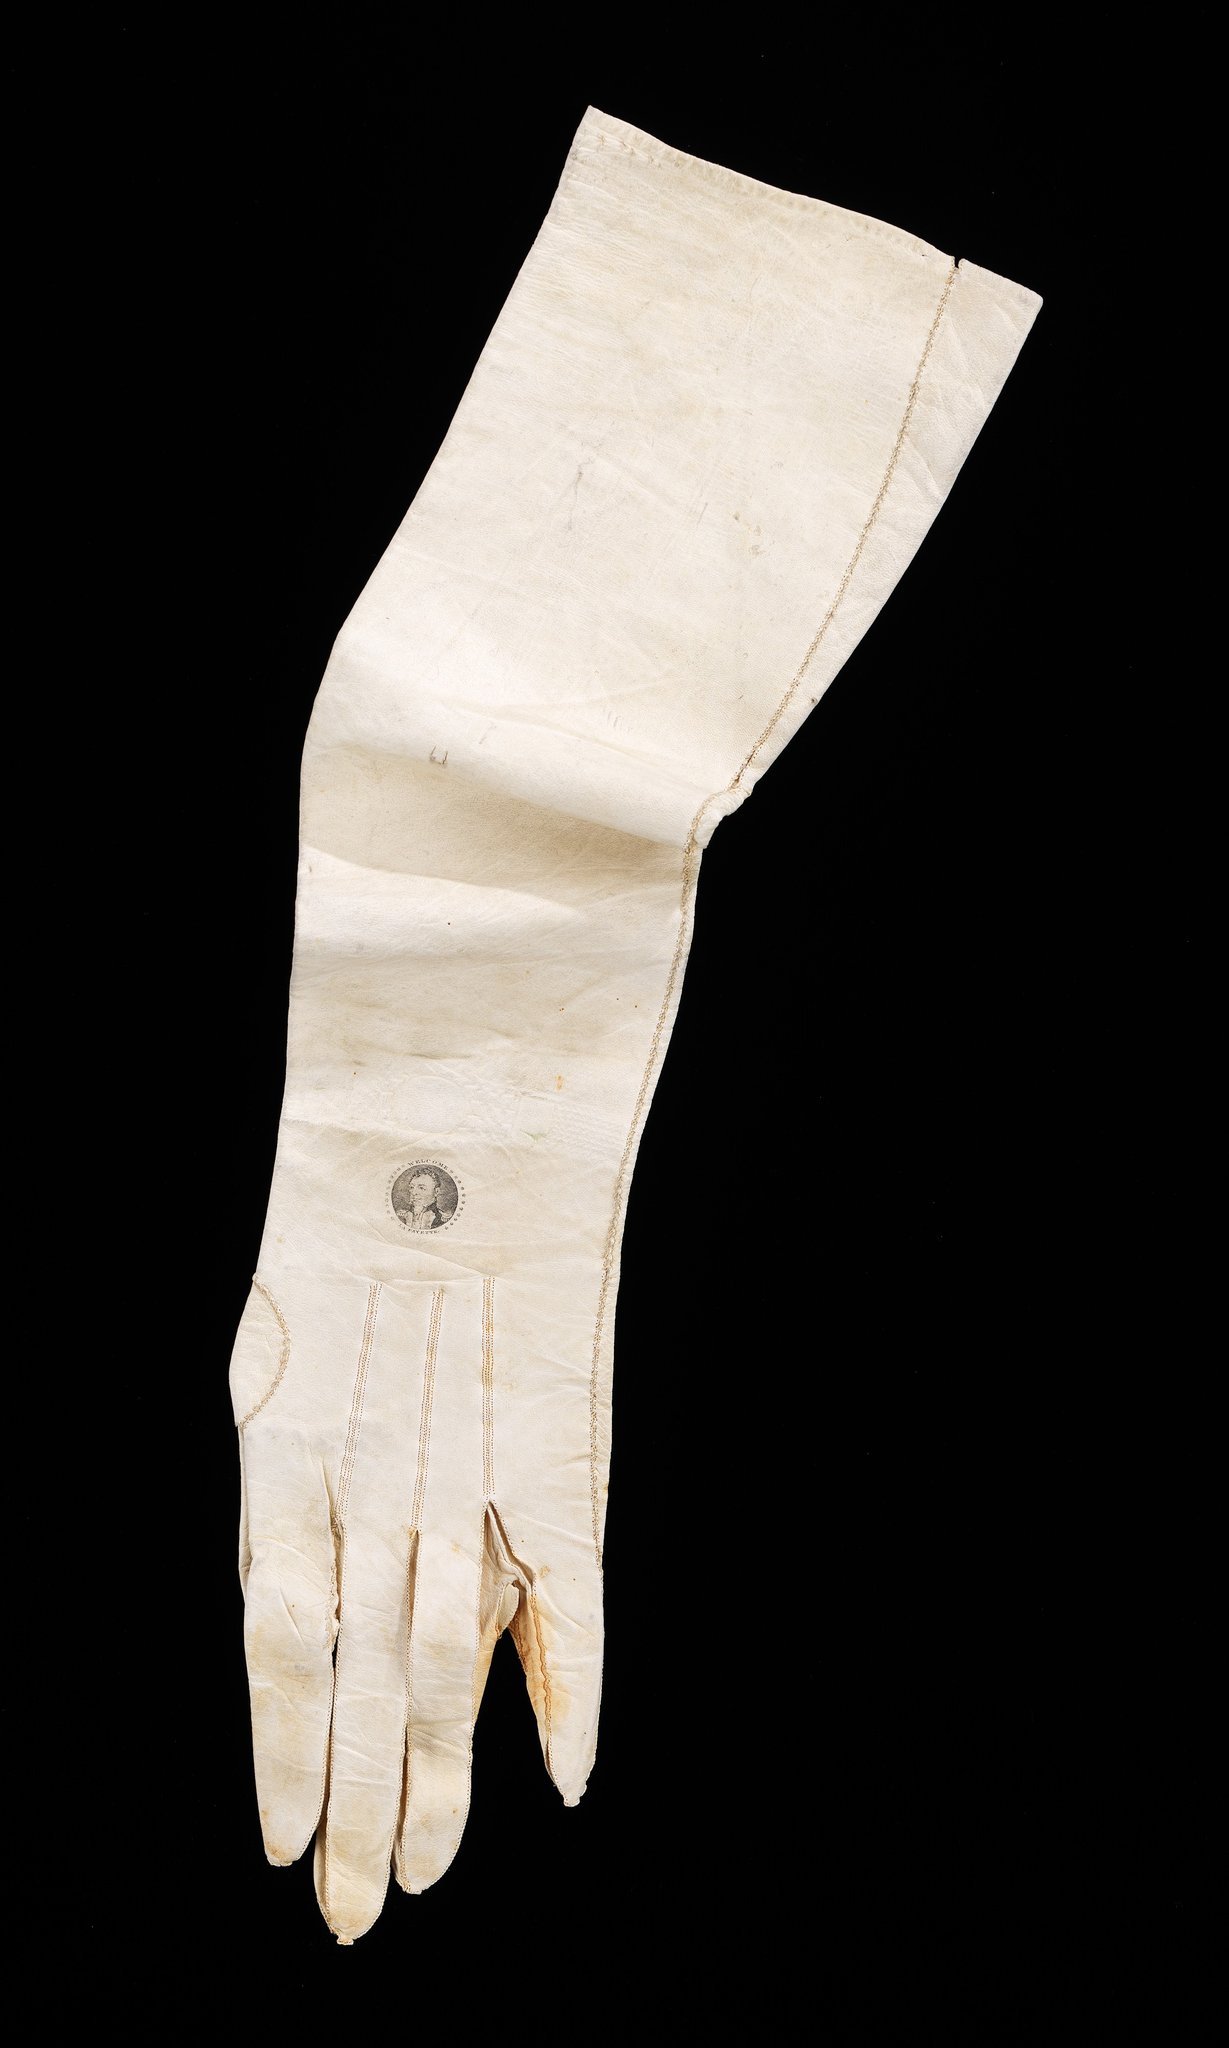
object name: glove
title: Gloves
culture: american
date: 1824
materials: leather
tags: men,portraits